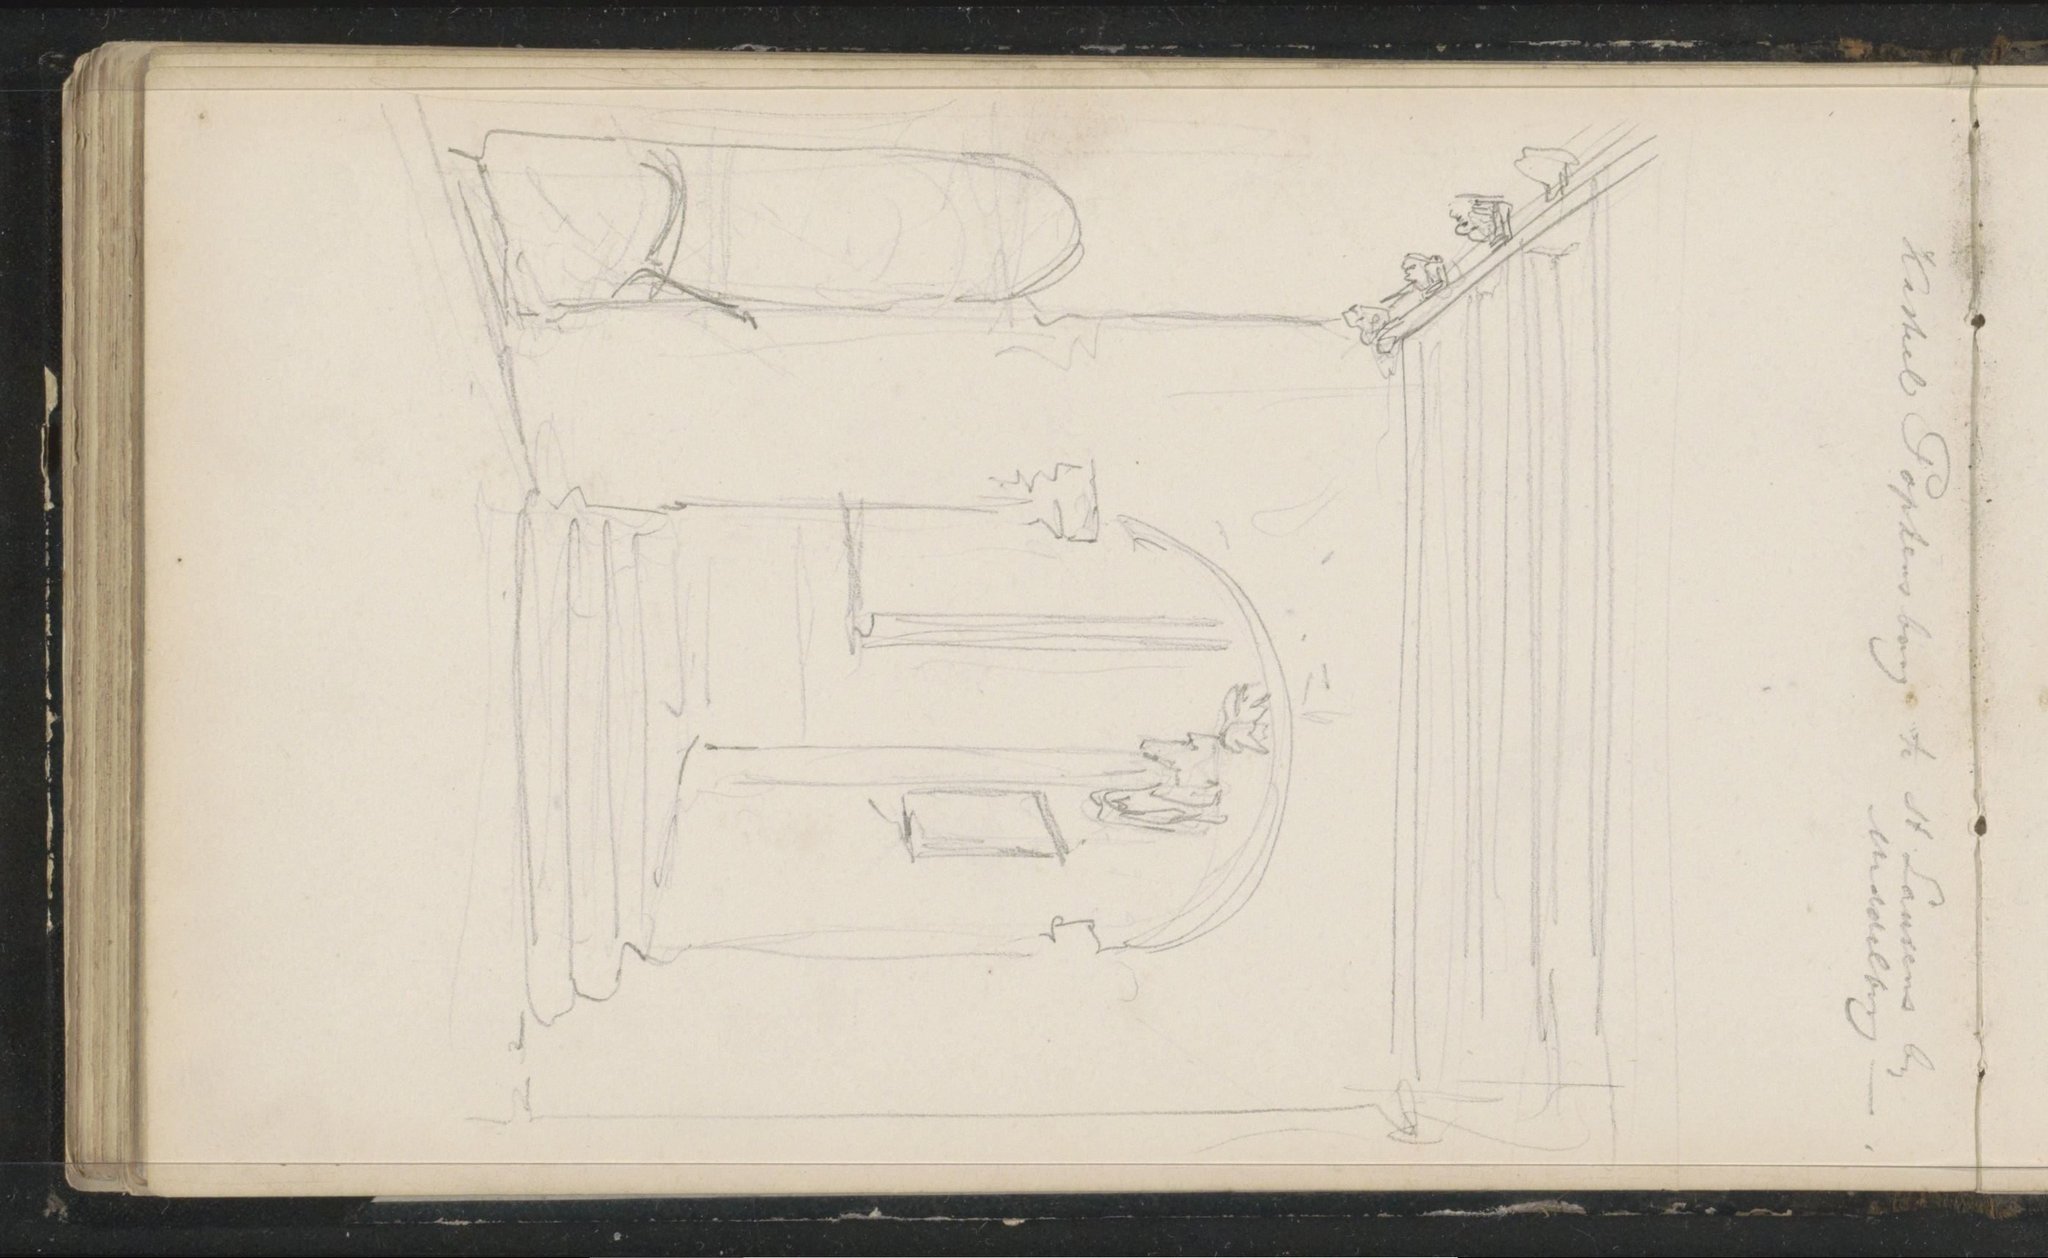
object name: sketchbook leaf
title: Gezicht op een openstaande poort van Kasteel Popkensburg te Sint Laurens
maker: cornelis springer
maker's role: draughtsman, painter, print maker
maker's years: 1817-1891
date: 1856-1861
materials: paper, pencil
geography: sint laurens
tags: castle, gate, entrance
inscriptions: annotation: ‘Kasteel Popkensburg te St. Laurens by/ Middelburg’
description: Gezicht op een openstaande poort van Kasteel Popkensburg te Sint Laurens. Blad 40 verso uit een schetsboek met 44 bladen vervaardigd in Zeeland en Utrecht.